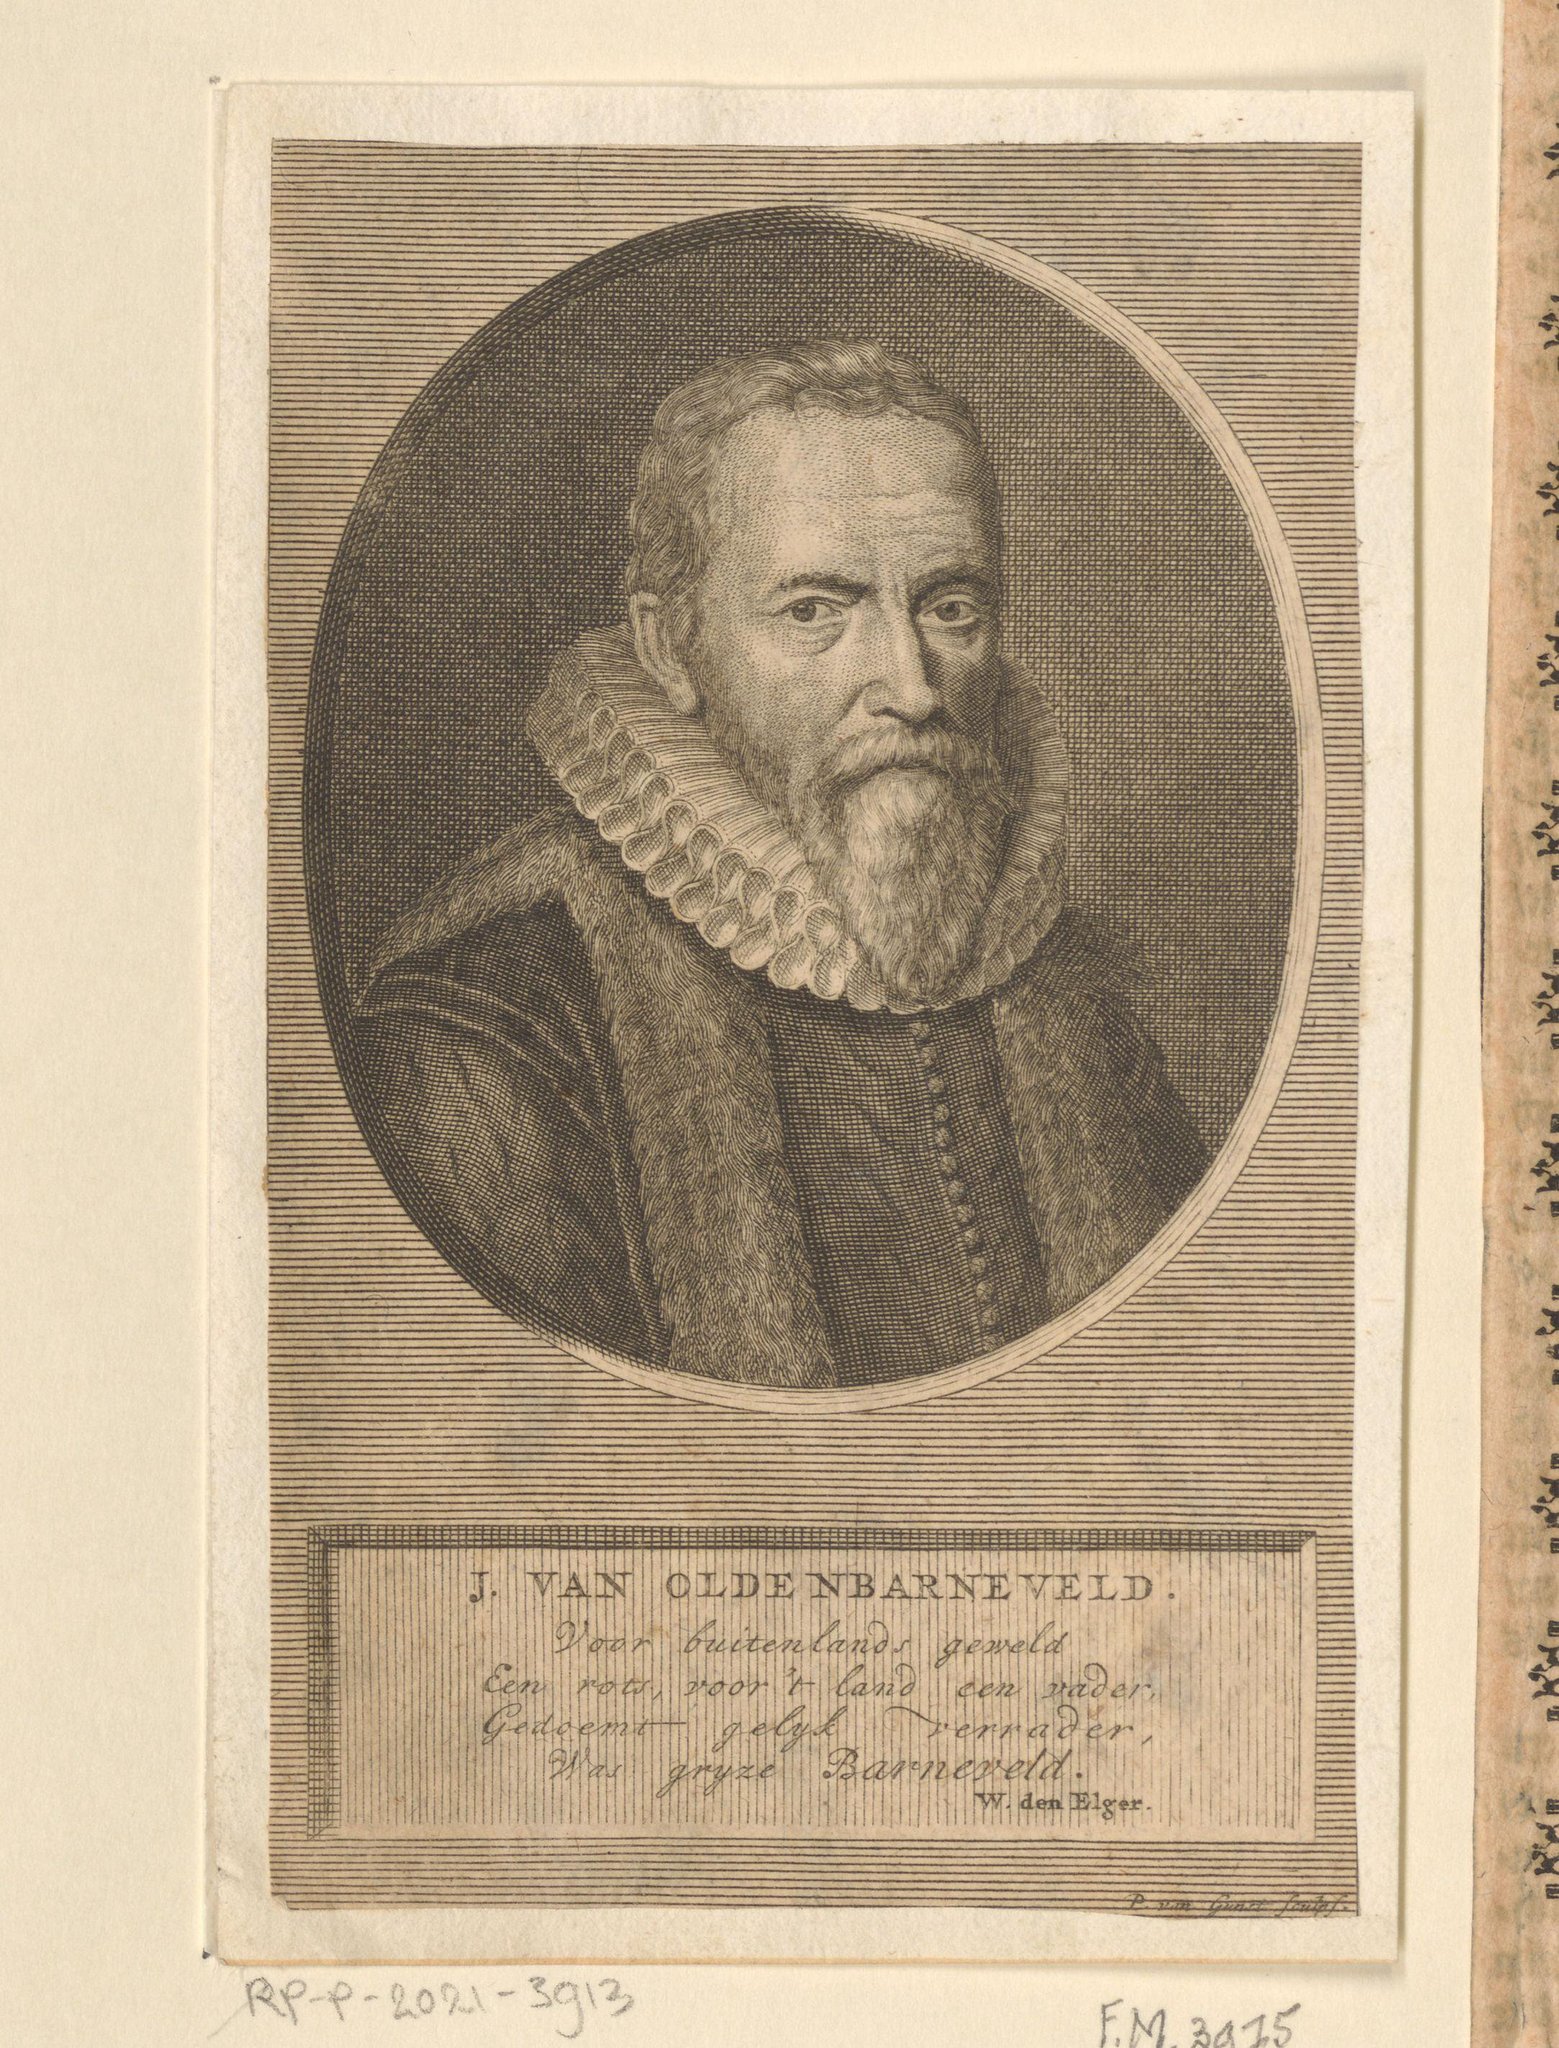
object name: print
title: Portret van Johan van Oldenbarnevelt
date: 1669-1731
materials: paper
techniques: engraving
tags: the hague, johan van oldenbarnevelt, historical persons